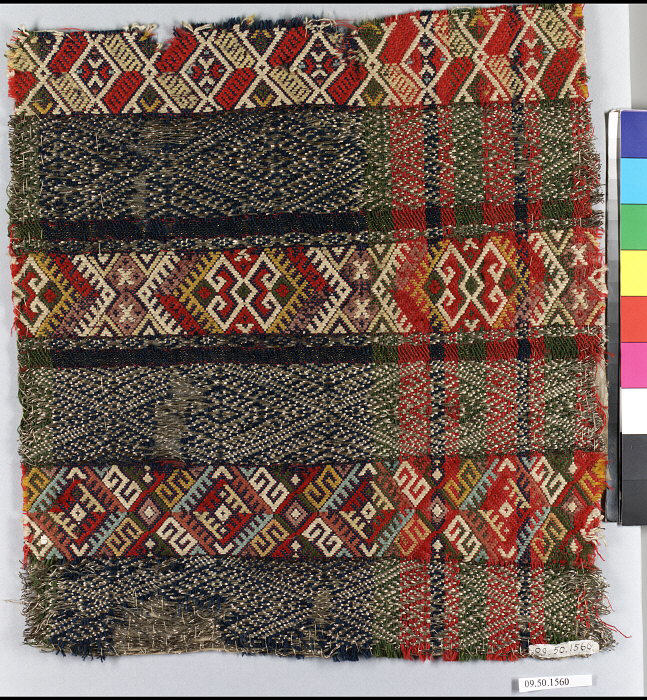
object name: fragment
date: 1801-1900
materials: metal thread, wool